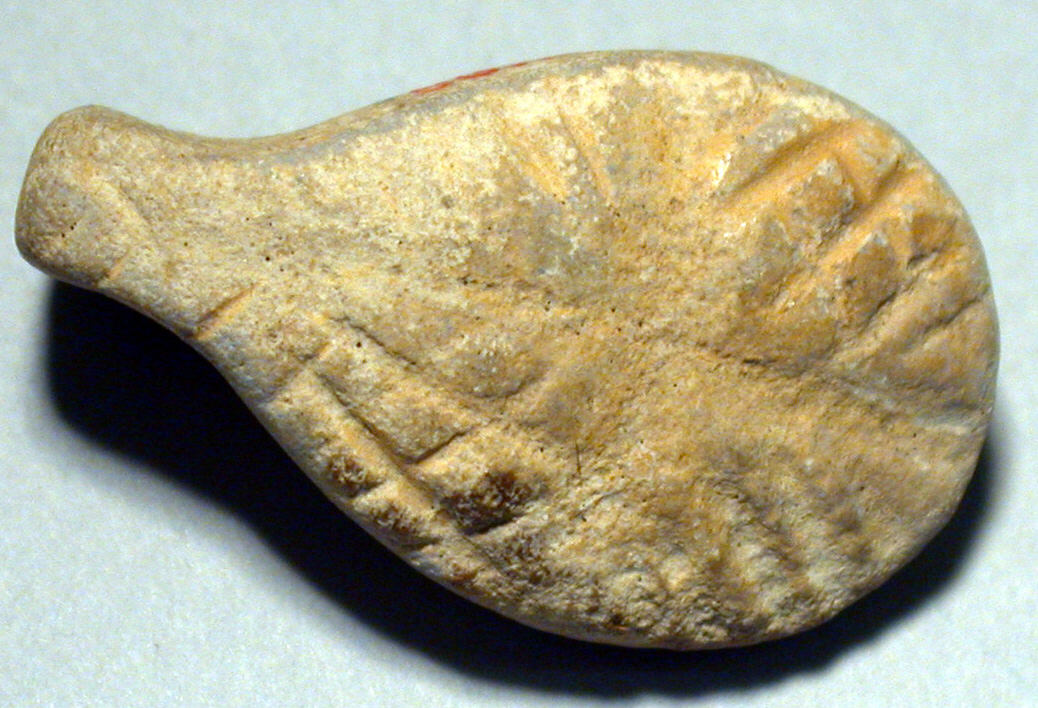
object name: necklace, bead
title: Amulet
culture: halaf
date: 4200 BCE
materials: limestone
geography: mesopotamia